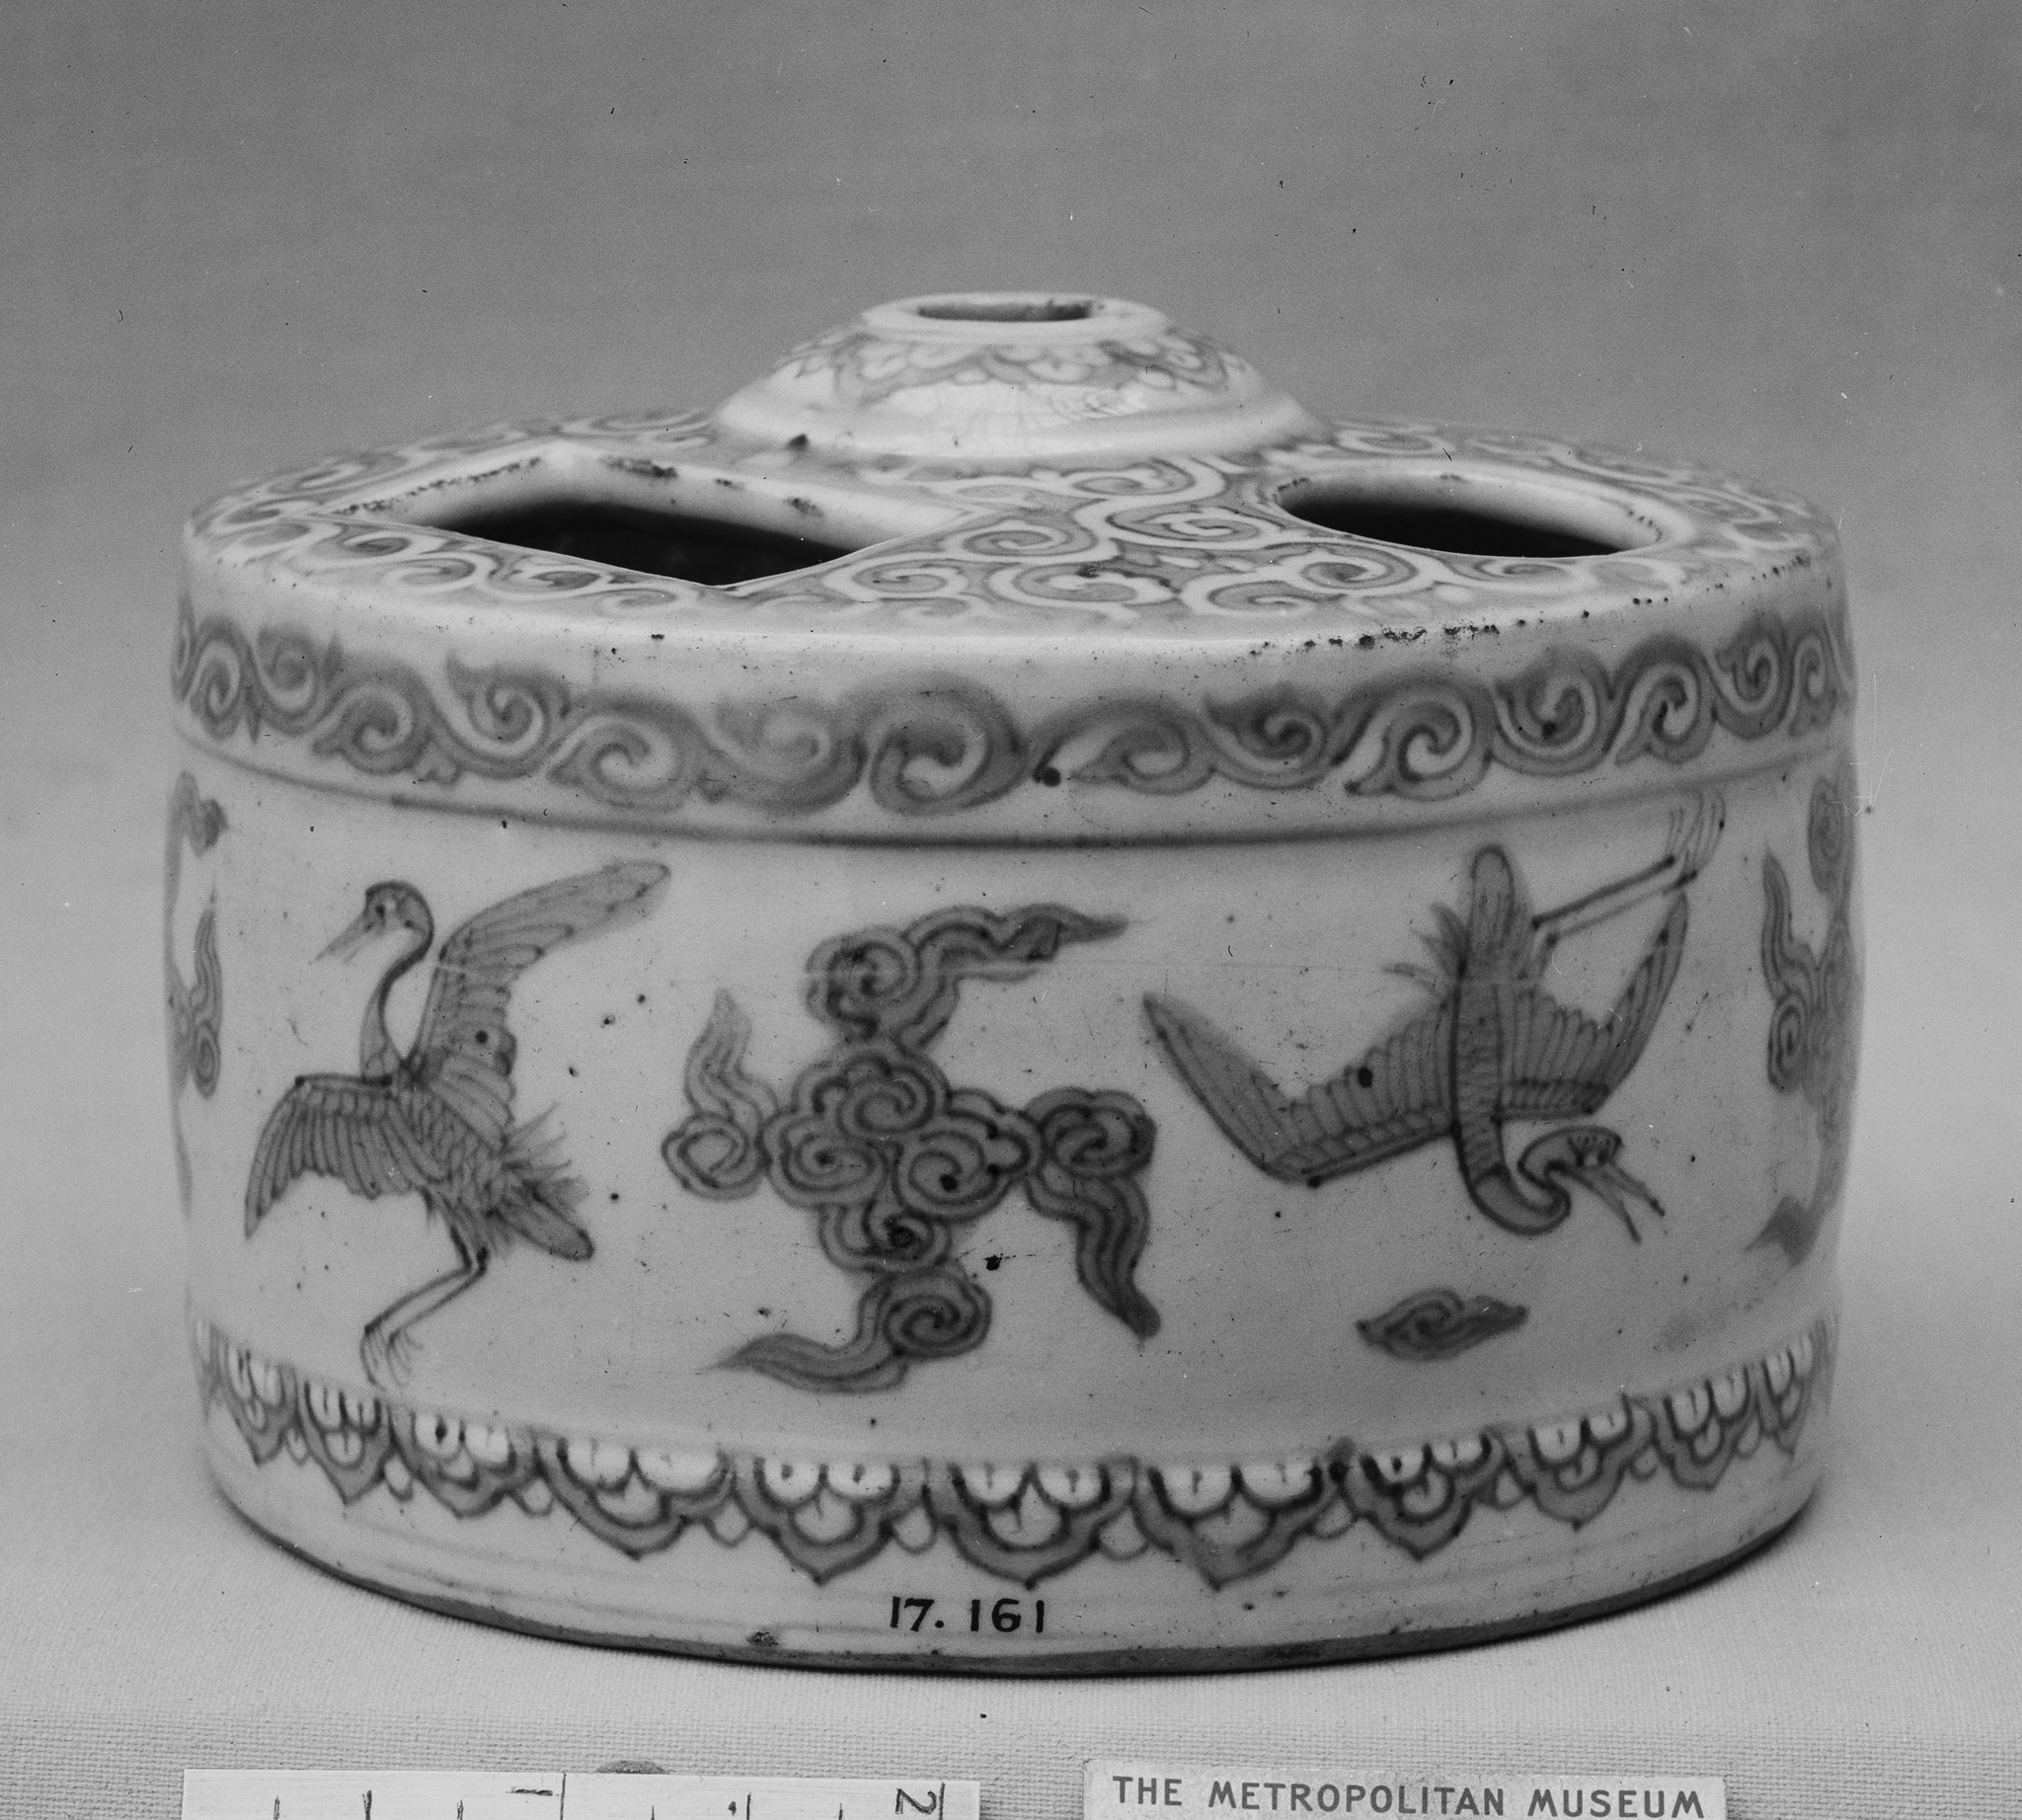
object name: brush holder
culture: chinese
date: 1573-1620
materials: cobalt, glaze, porcelain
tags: birds